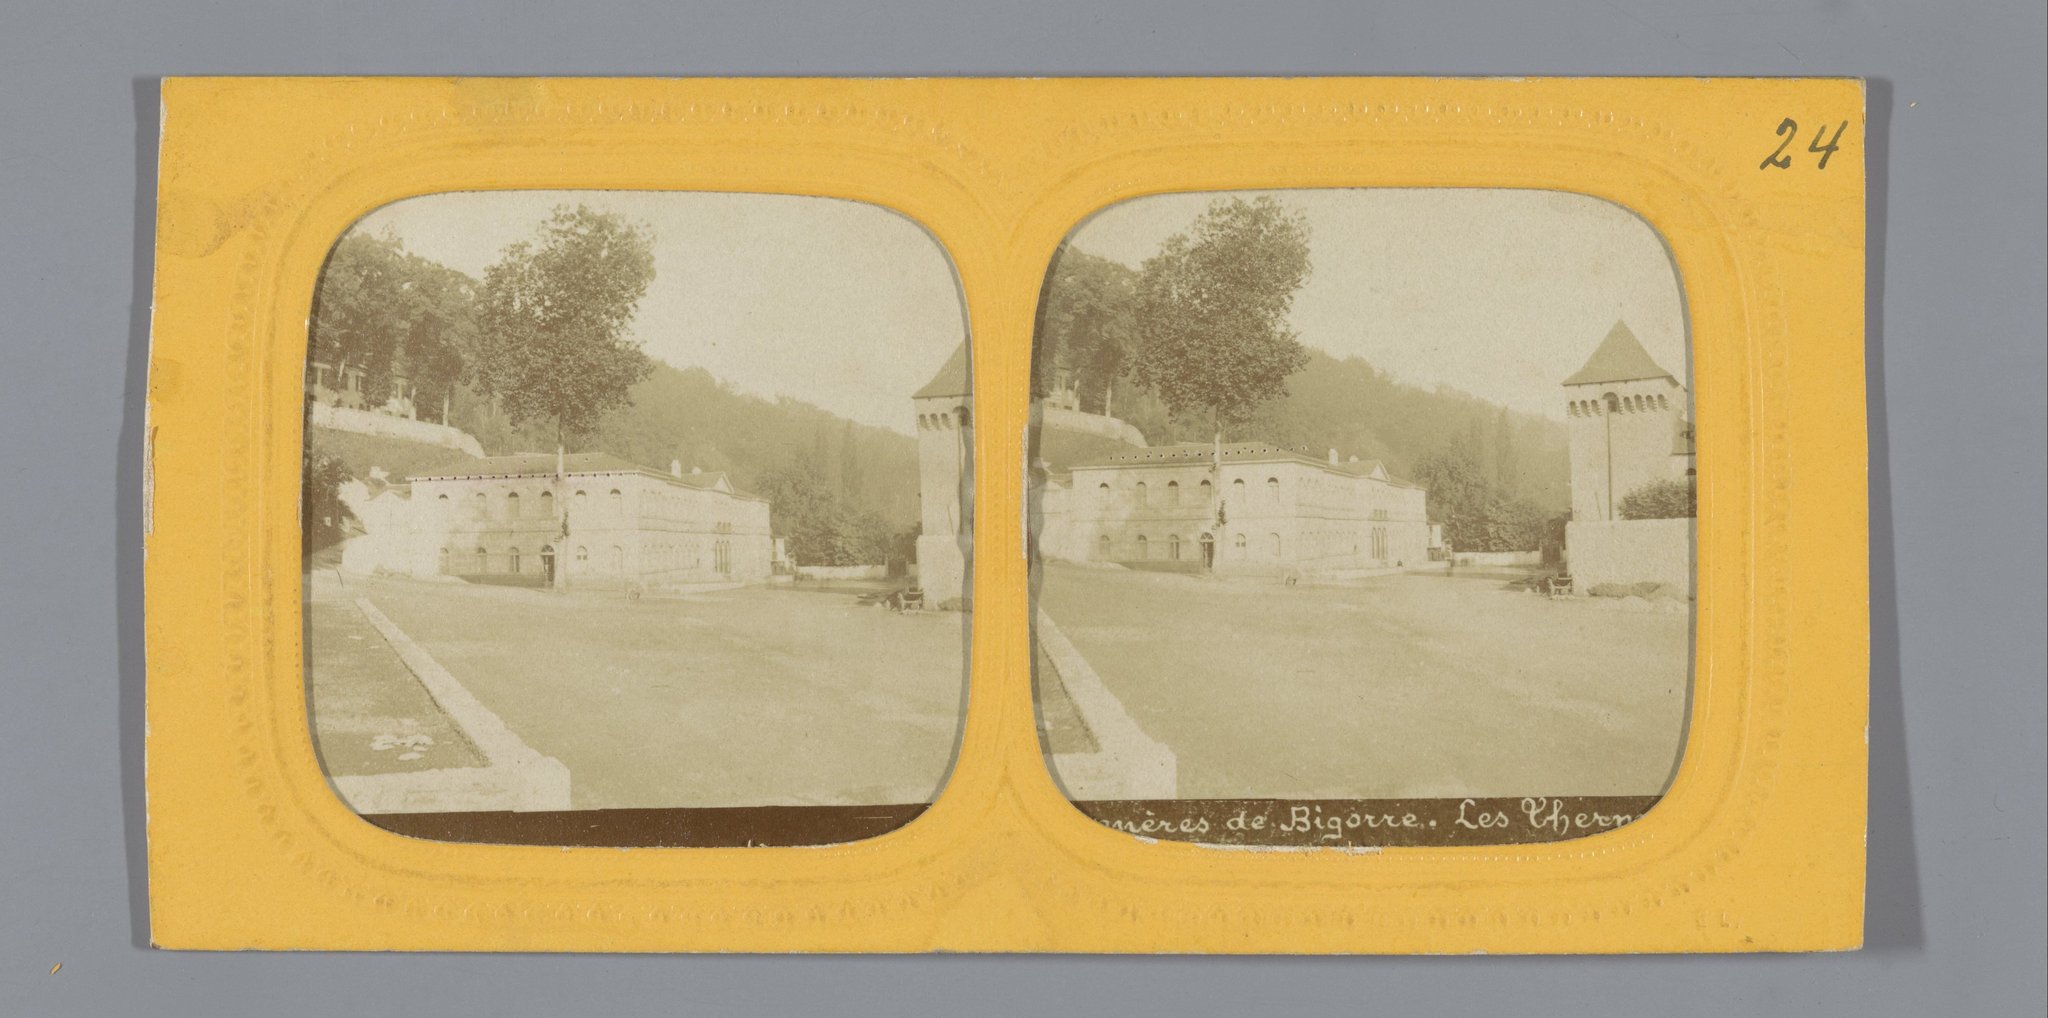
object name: tissue stereograph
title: Bagnères-de-Bigorre. Les Thermes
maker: Anonymous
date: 1855-1875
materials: cardboard, paper, photographic support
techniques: albumen print, hand coloring, perforating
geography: bagnères-de-bigorre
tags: watering-place, spa, village square, place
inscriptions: number: ‘24’, monogram: ‘E.L.’